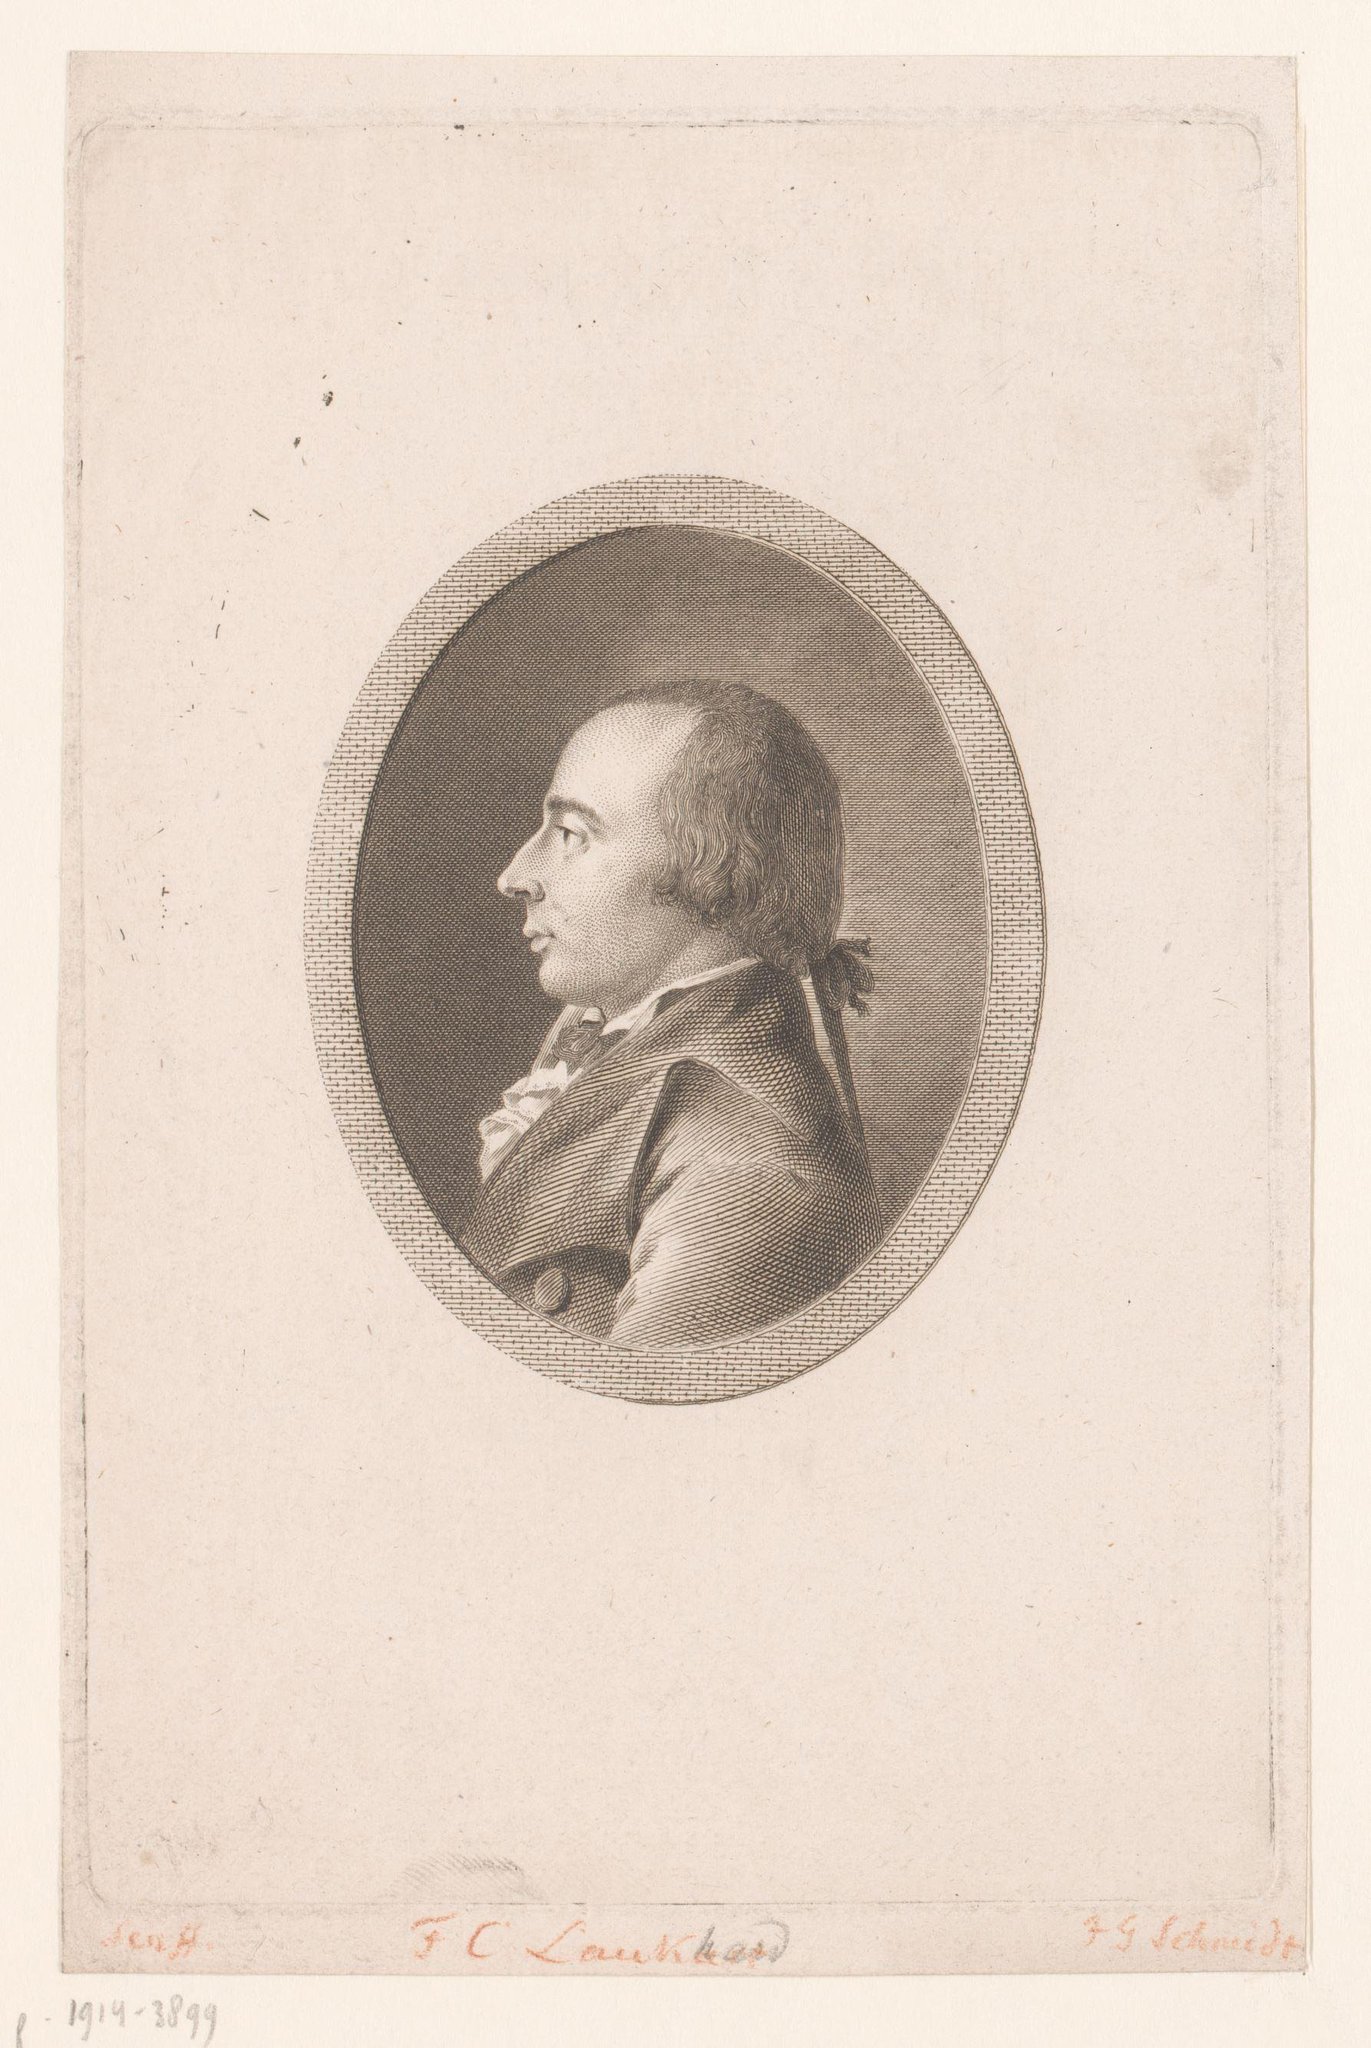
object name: print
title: Portret van Friedrich Christian Laukhard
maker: georg christoph schmidt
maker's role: print maker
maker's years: 1740-1811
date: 1796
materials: paper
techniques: engraving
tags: historical persons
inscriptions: collector's mark: Lugt 2228